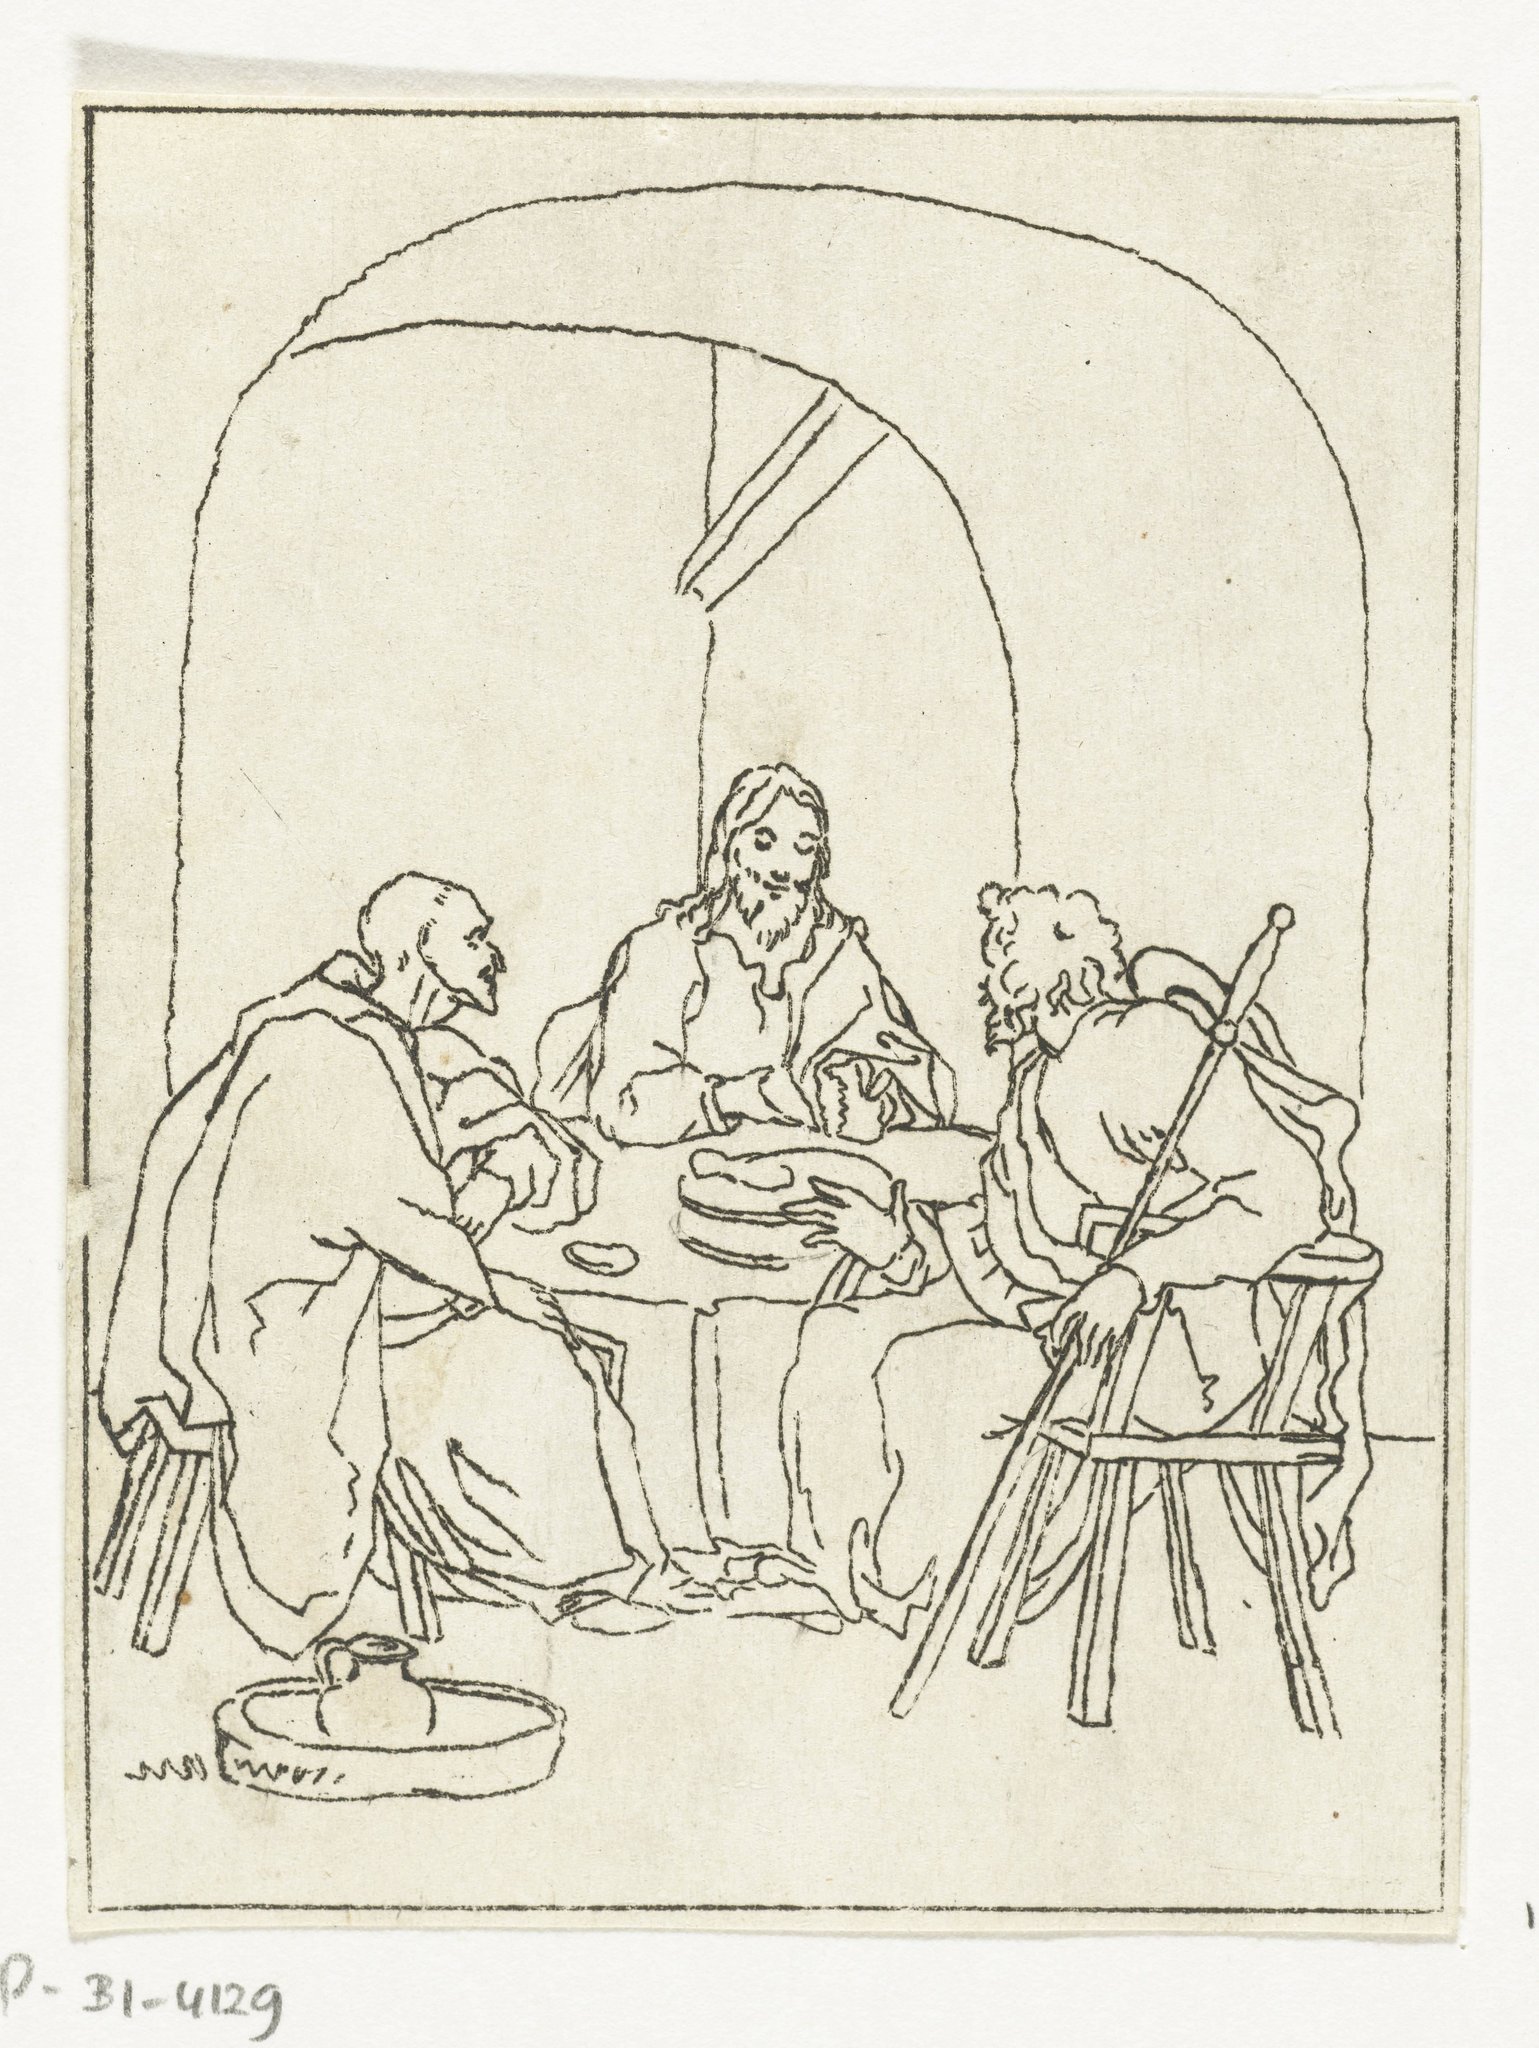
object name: print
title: Maaltijd te Emmaüs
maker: anthonie van den bos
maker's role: draughtsman, print maker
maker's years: 1763-1838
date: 1778-1838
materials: paper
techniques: etching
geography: netherlands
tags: the supper at emmaus: christ is recognized while blessing or breaking the bread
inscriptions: collector's mark: Lugt 2228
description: Christus zit met de Emmaüsgangers aan tafel. Hij breekt het brood en spreekt de zegen uit en op dat moment herkennen de twee mannen hem.